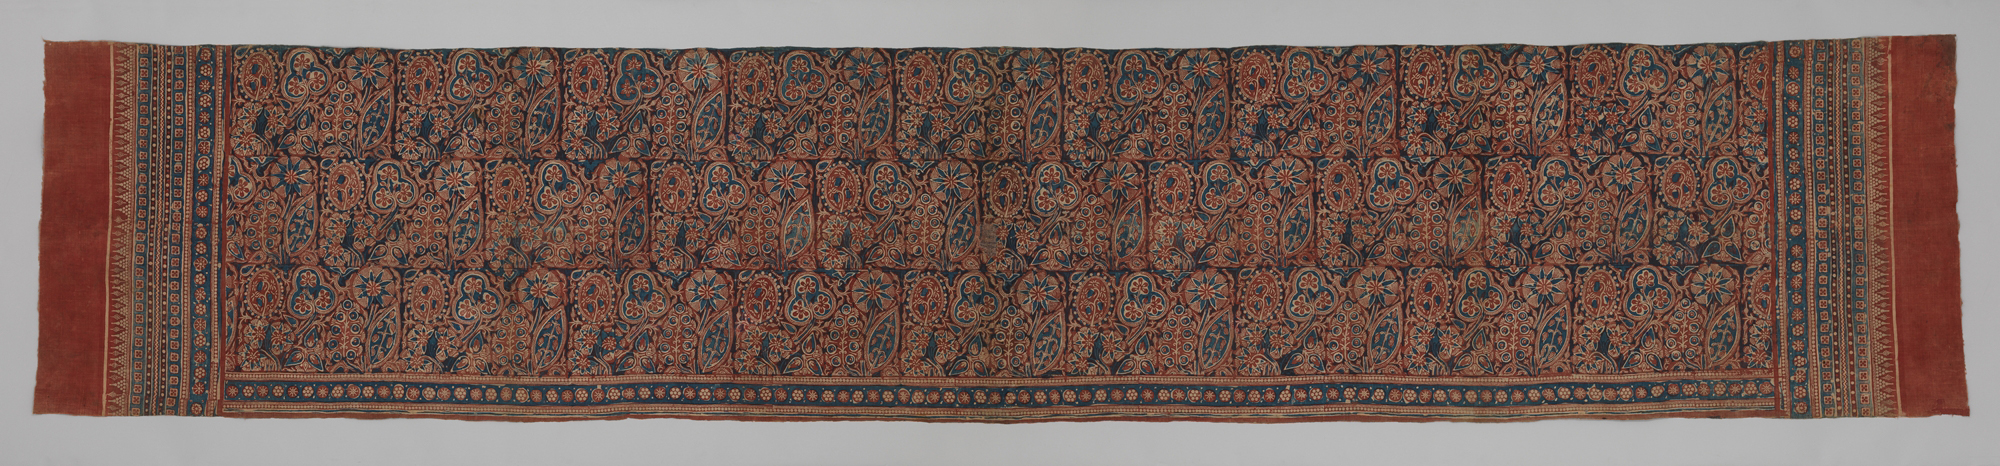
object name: textile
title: Textile with a Forested Landscape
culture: indian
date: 1367-1433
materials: cotton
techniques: dyeing, painting, printing, resist